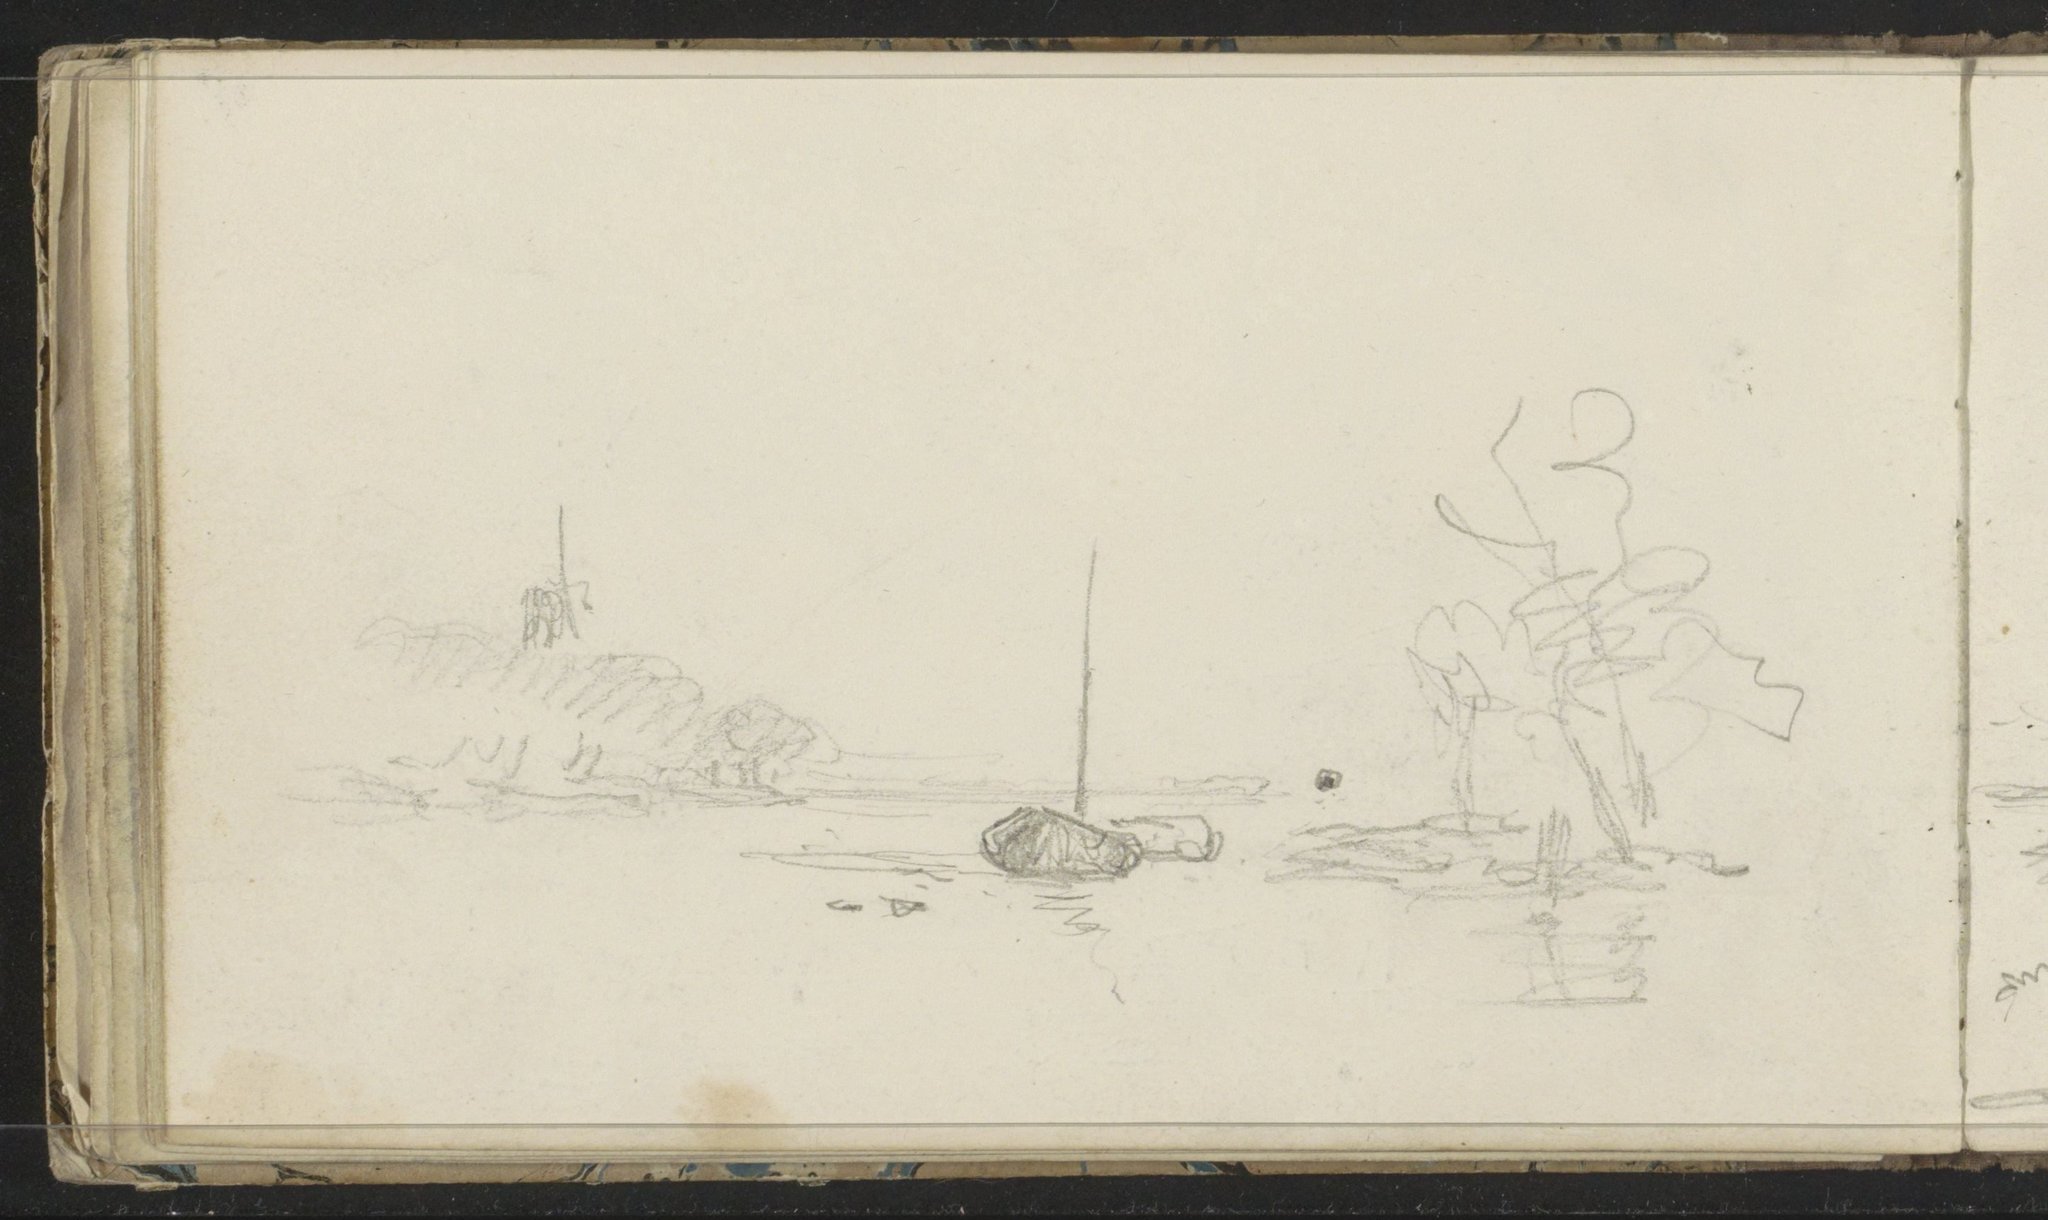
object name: sketchbook leaf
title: Rivierlandschap met molen en zeilboot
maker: arnoldus johannes eymer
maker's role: draughtsman, print maker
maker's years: 1803-1863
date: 1803-1818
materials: paper, pencil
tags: sailing-ship, sailing-boat, windmill in landscape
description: Bladzijde 46 uit een schetsboek met 74 bladzijden.